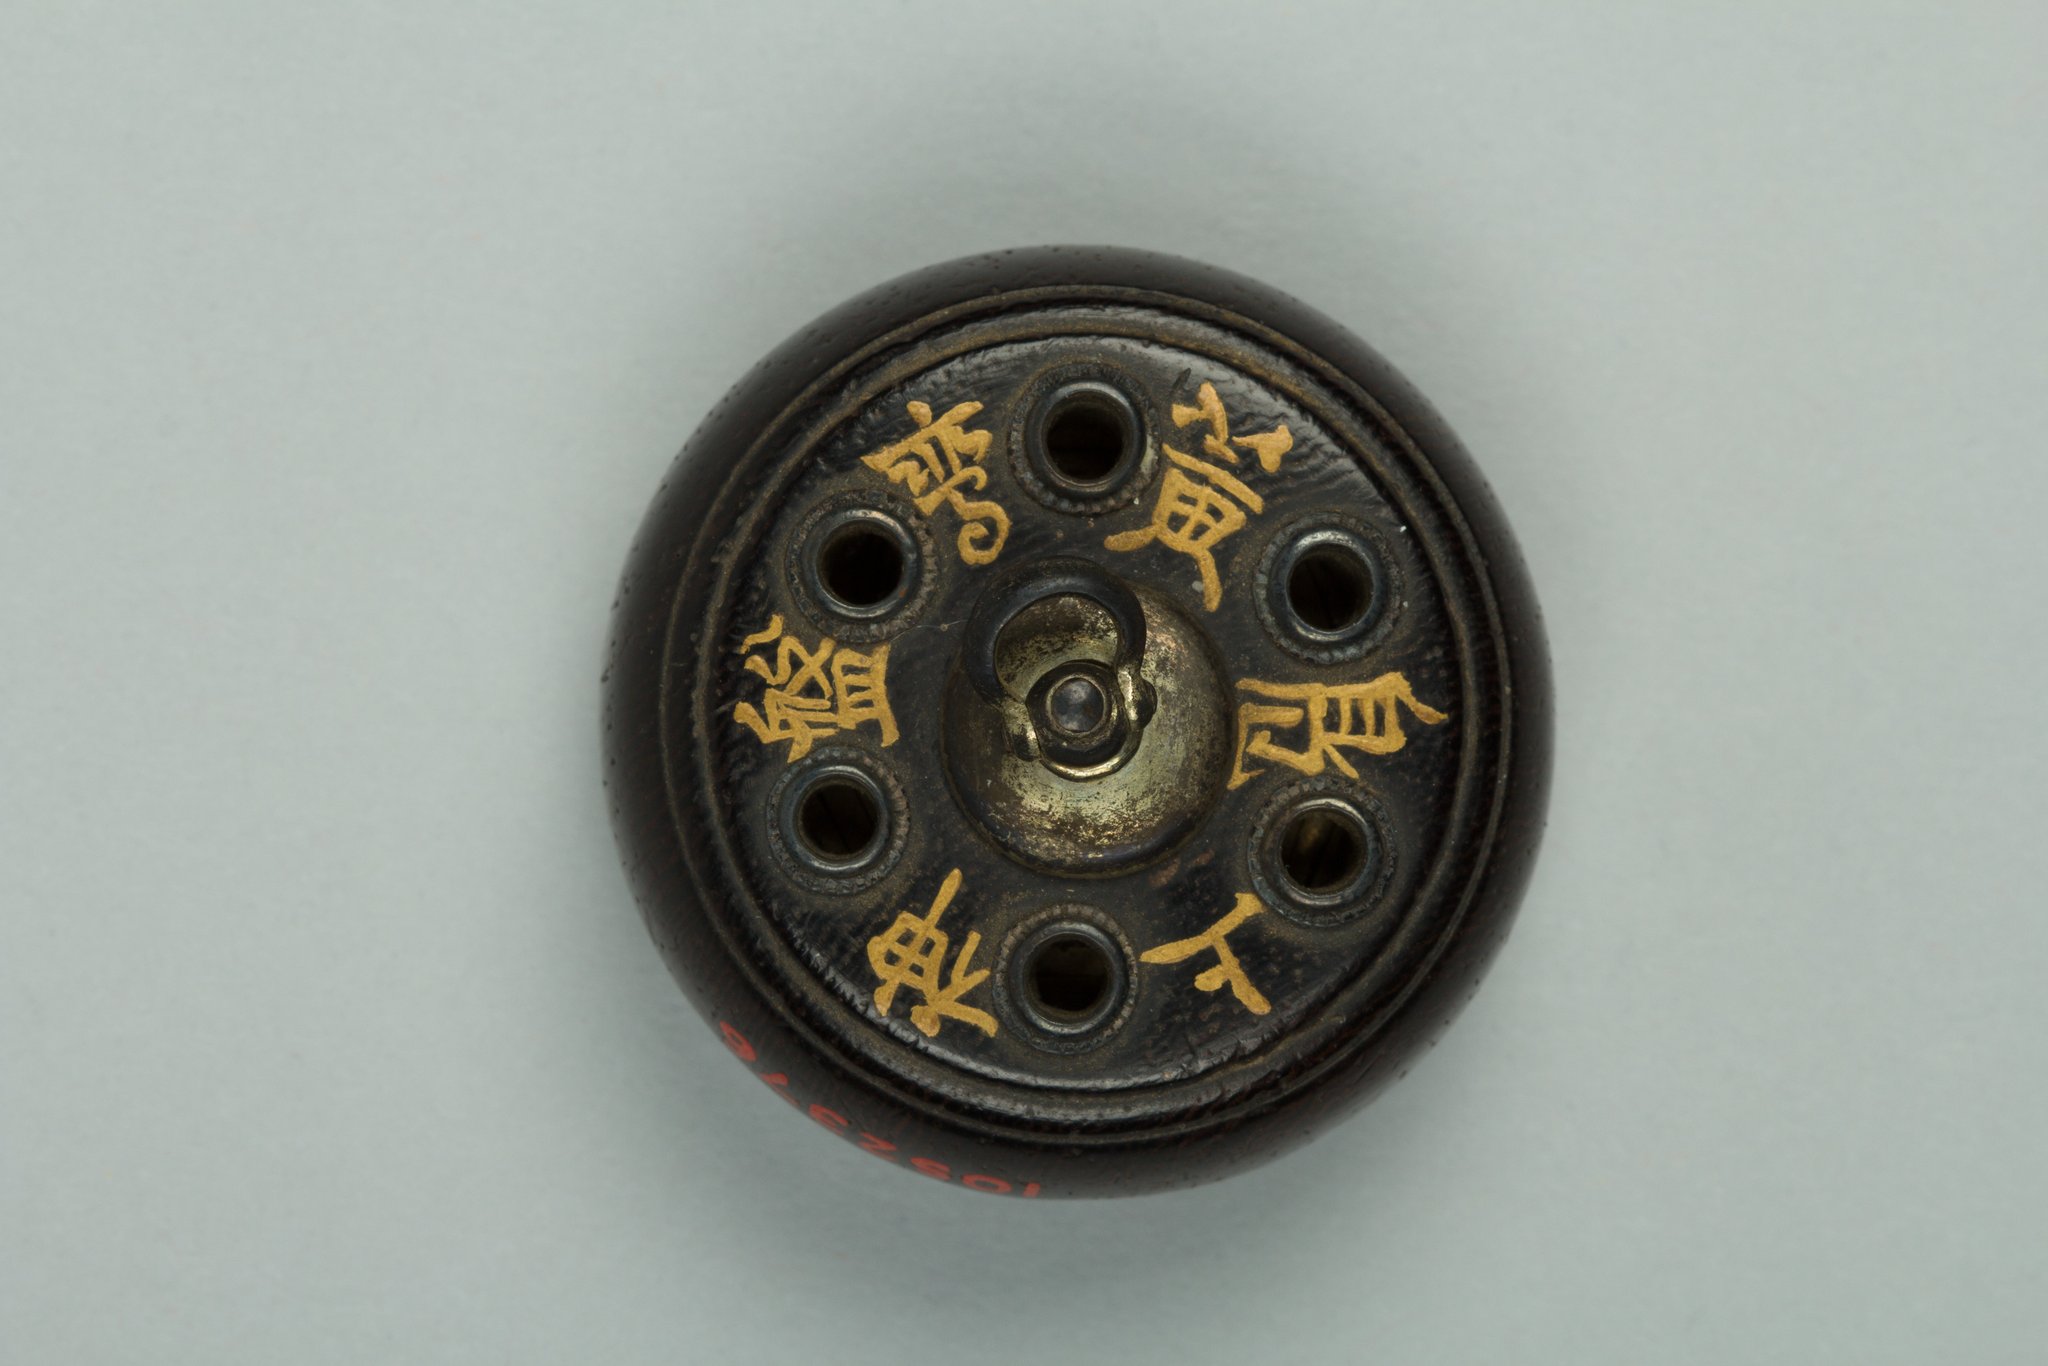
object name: netsuke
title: Netsuke with Inscription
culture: japanese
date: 1801-1900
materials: wood